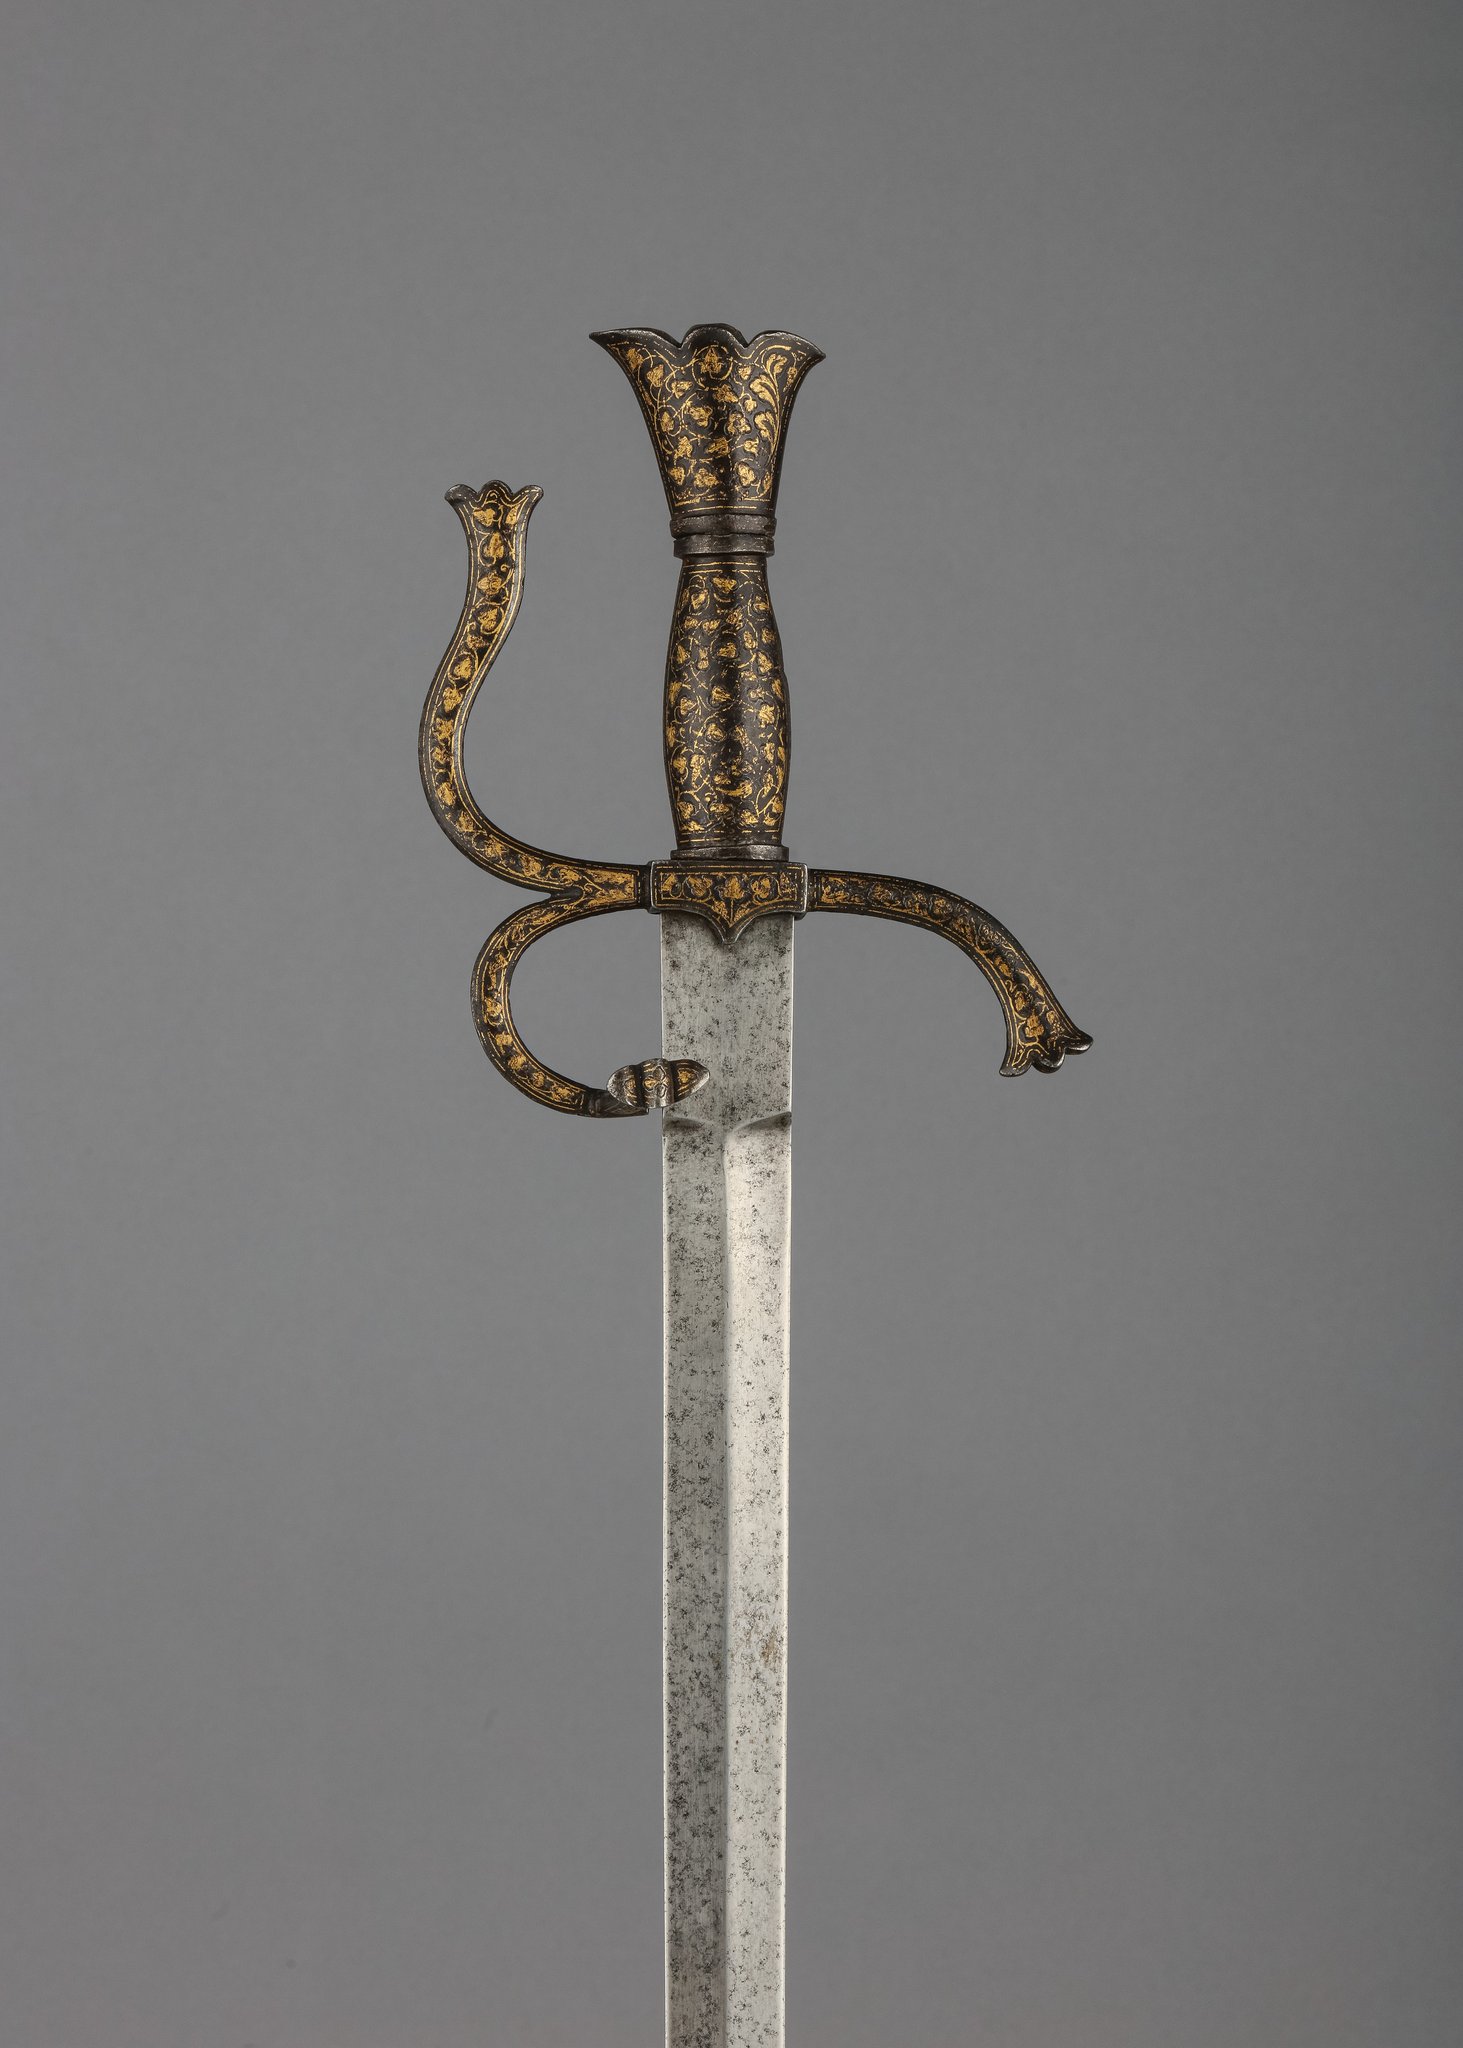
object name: smallsword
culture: italian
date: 1600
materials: gold, steel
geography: italy